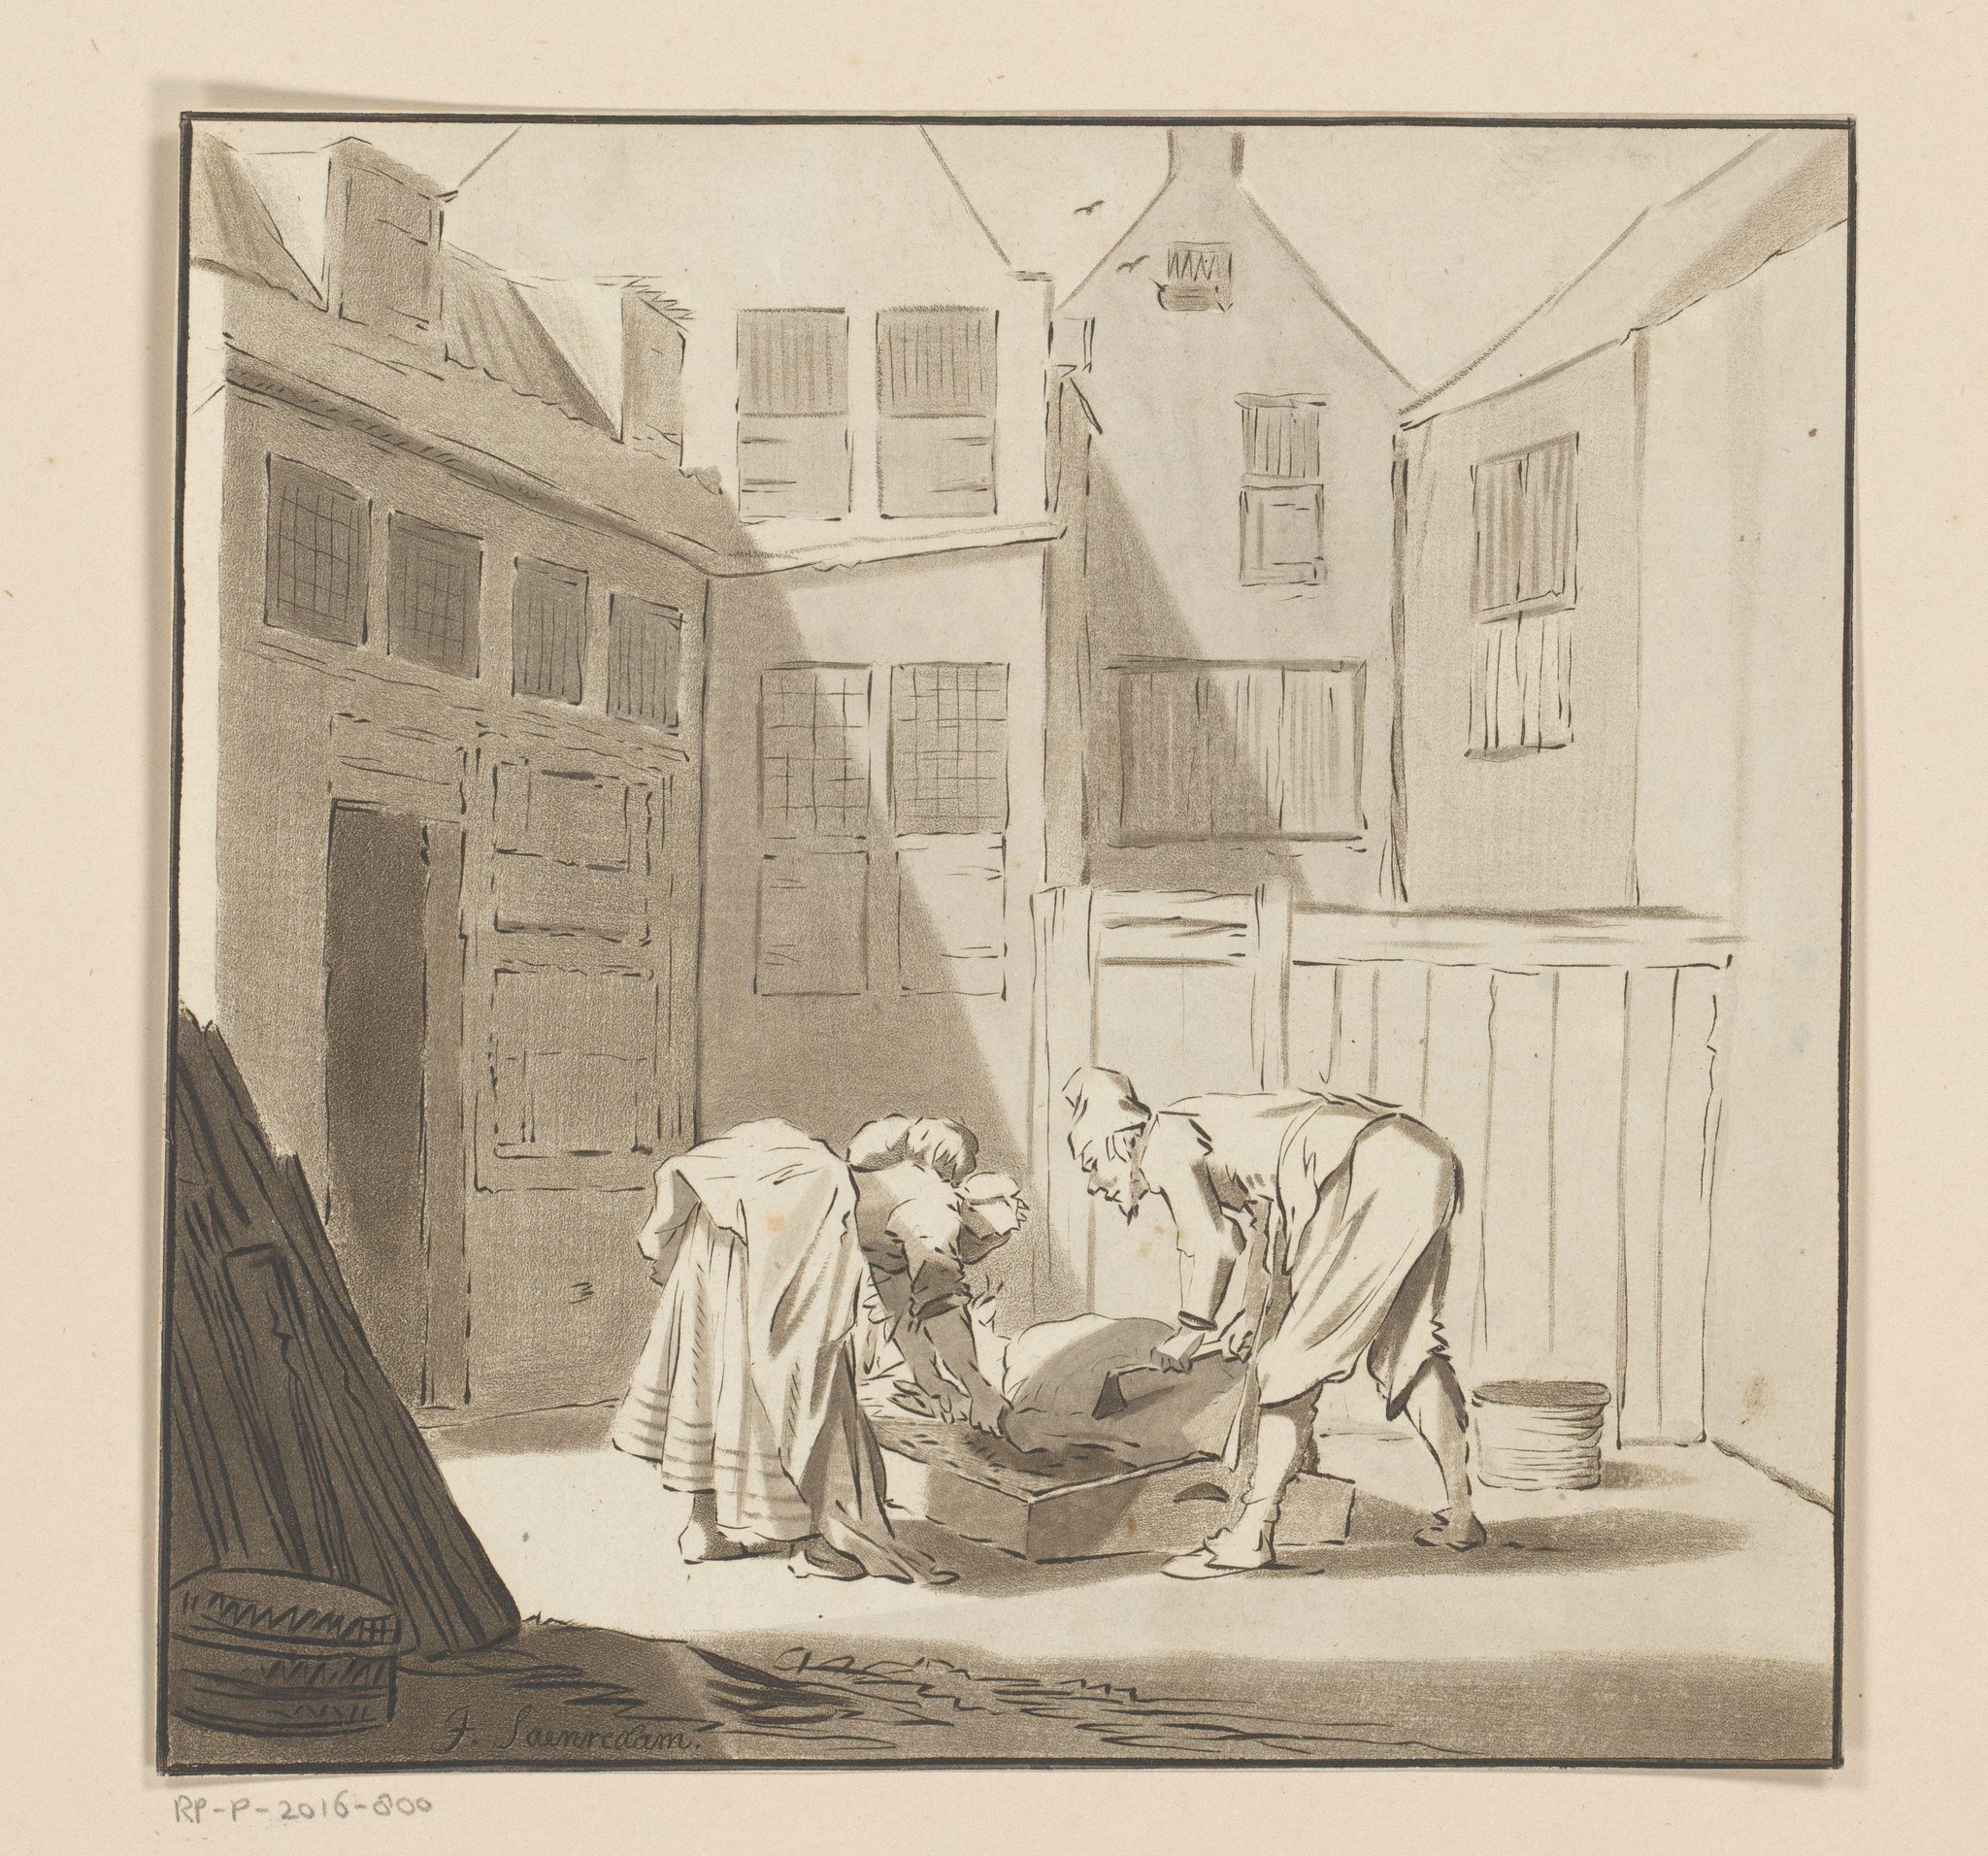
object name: print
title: Varkensslacht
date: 1778-1787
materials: paper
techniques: etching, hand coloring, roulette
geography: amsterdam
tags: slaughtered ox or pig, butcher, slaughterman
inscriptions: collector's mark: Lugt 2725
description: Op een binnenplaats slachten een man en een vrouw een varken. De prent ligt los in een album, zie blad 41.